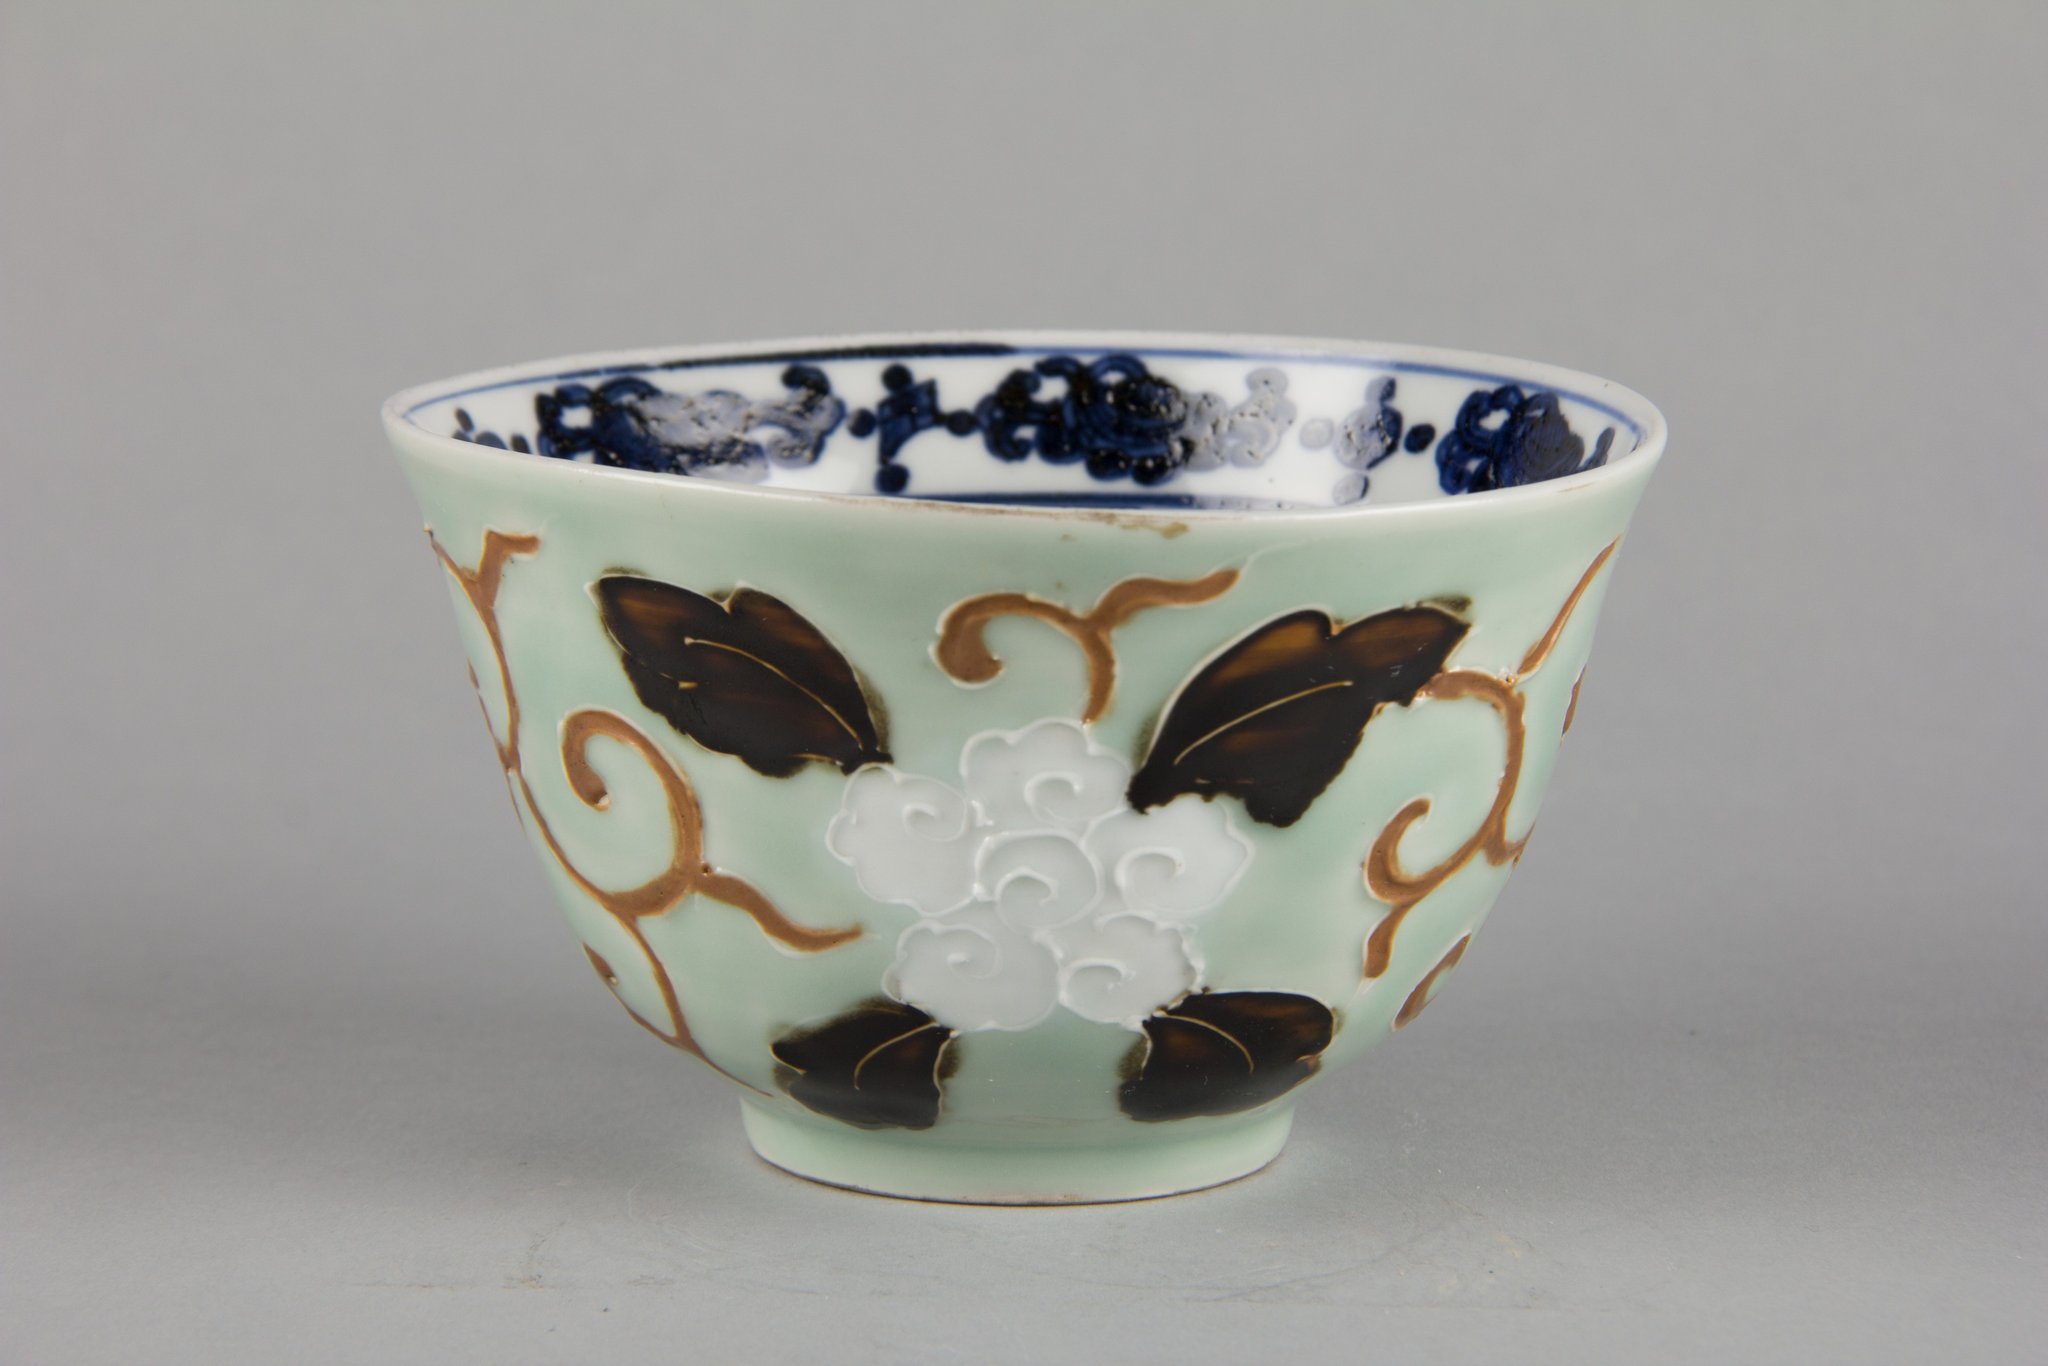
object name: bowl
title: Bowl with dragon and floral pattern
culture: chinese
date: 1801-1900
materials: ceramic glaze, cobalt, glaze, porcelain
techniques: painting, relief, underglaze